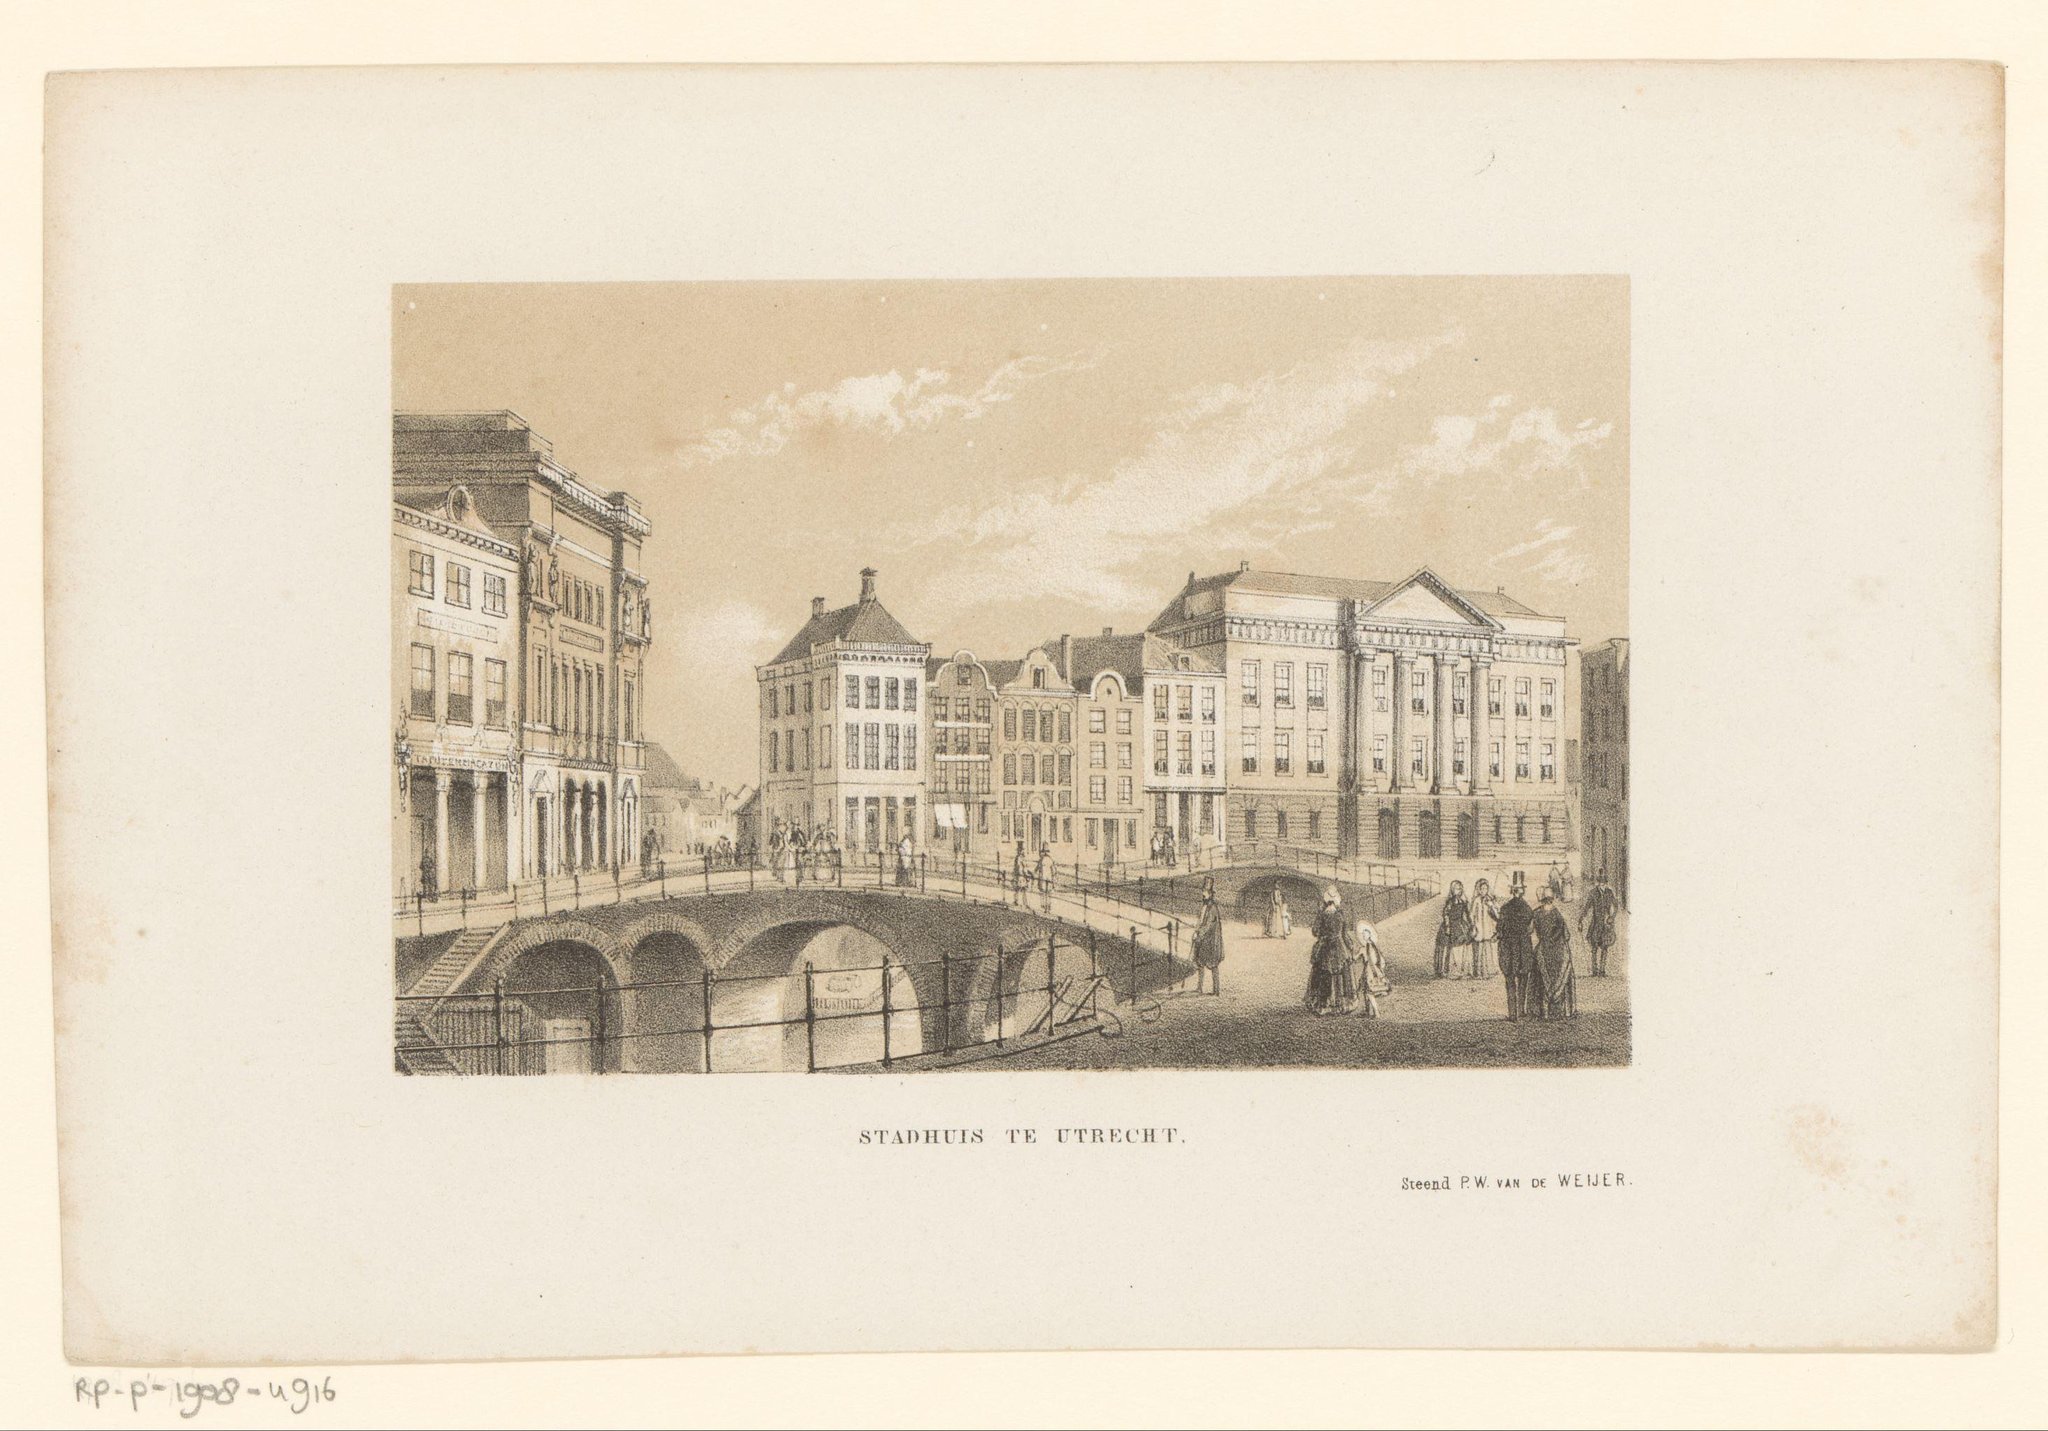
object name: print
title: Stadhuis te Utrecht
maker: pieter wilhelmus van de weijer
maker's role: print maker, printer, publisher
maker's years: 1816-1880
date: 1856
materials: paper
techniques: tone lithography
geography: utrecht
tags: city-view, and landscape with man-made constructions, townhall, canals, waters (in city), utrecht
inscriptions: collector's mark: Lugt 2228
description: Mogelijk maakte deze prent deel uit van: Utrecht's Album, Utrecht: W.F.Dannenfelser, 1856.